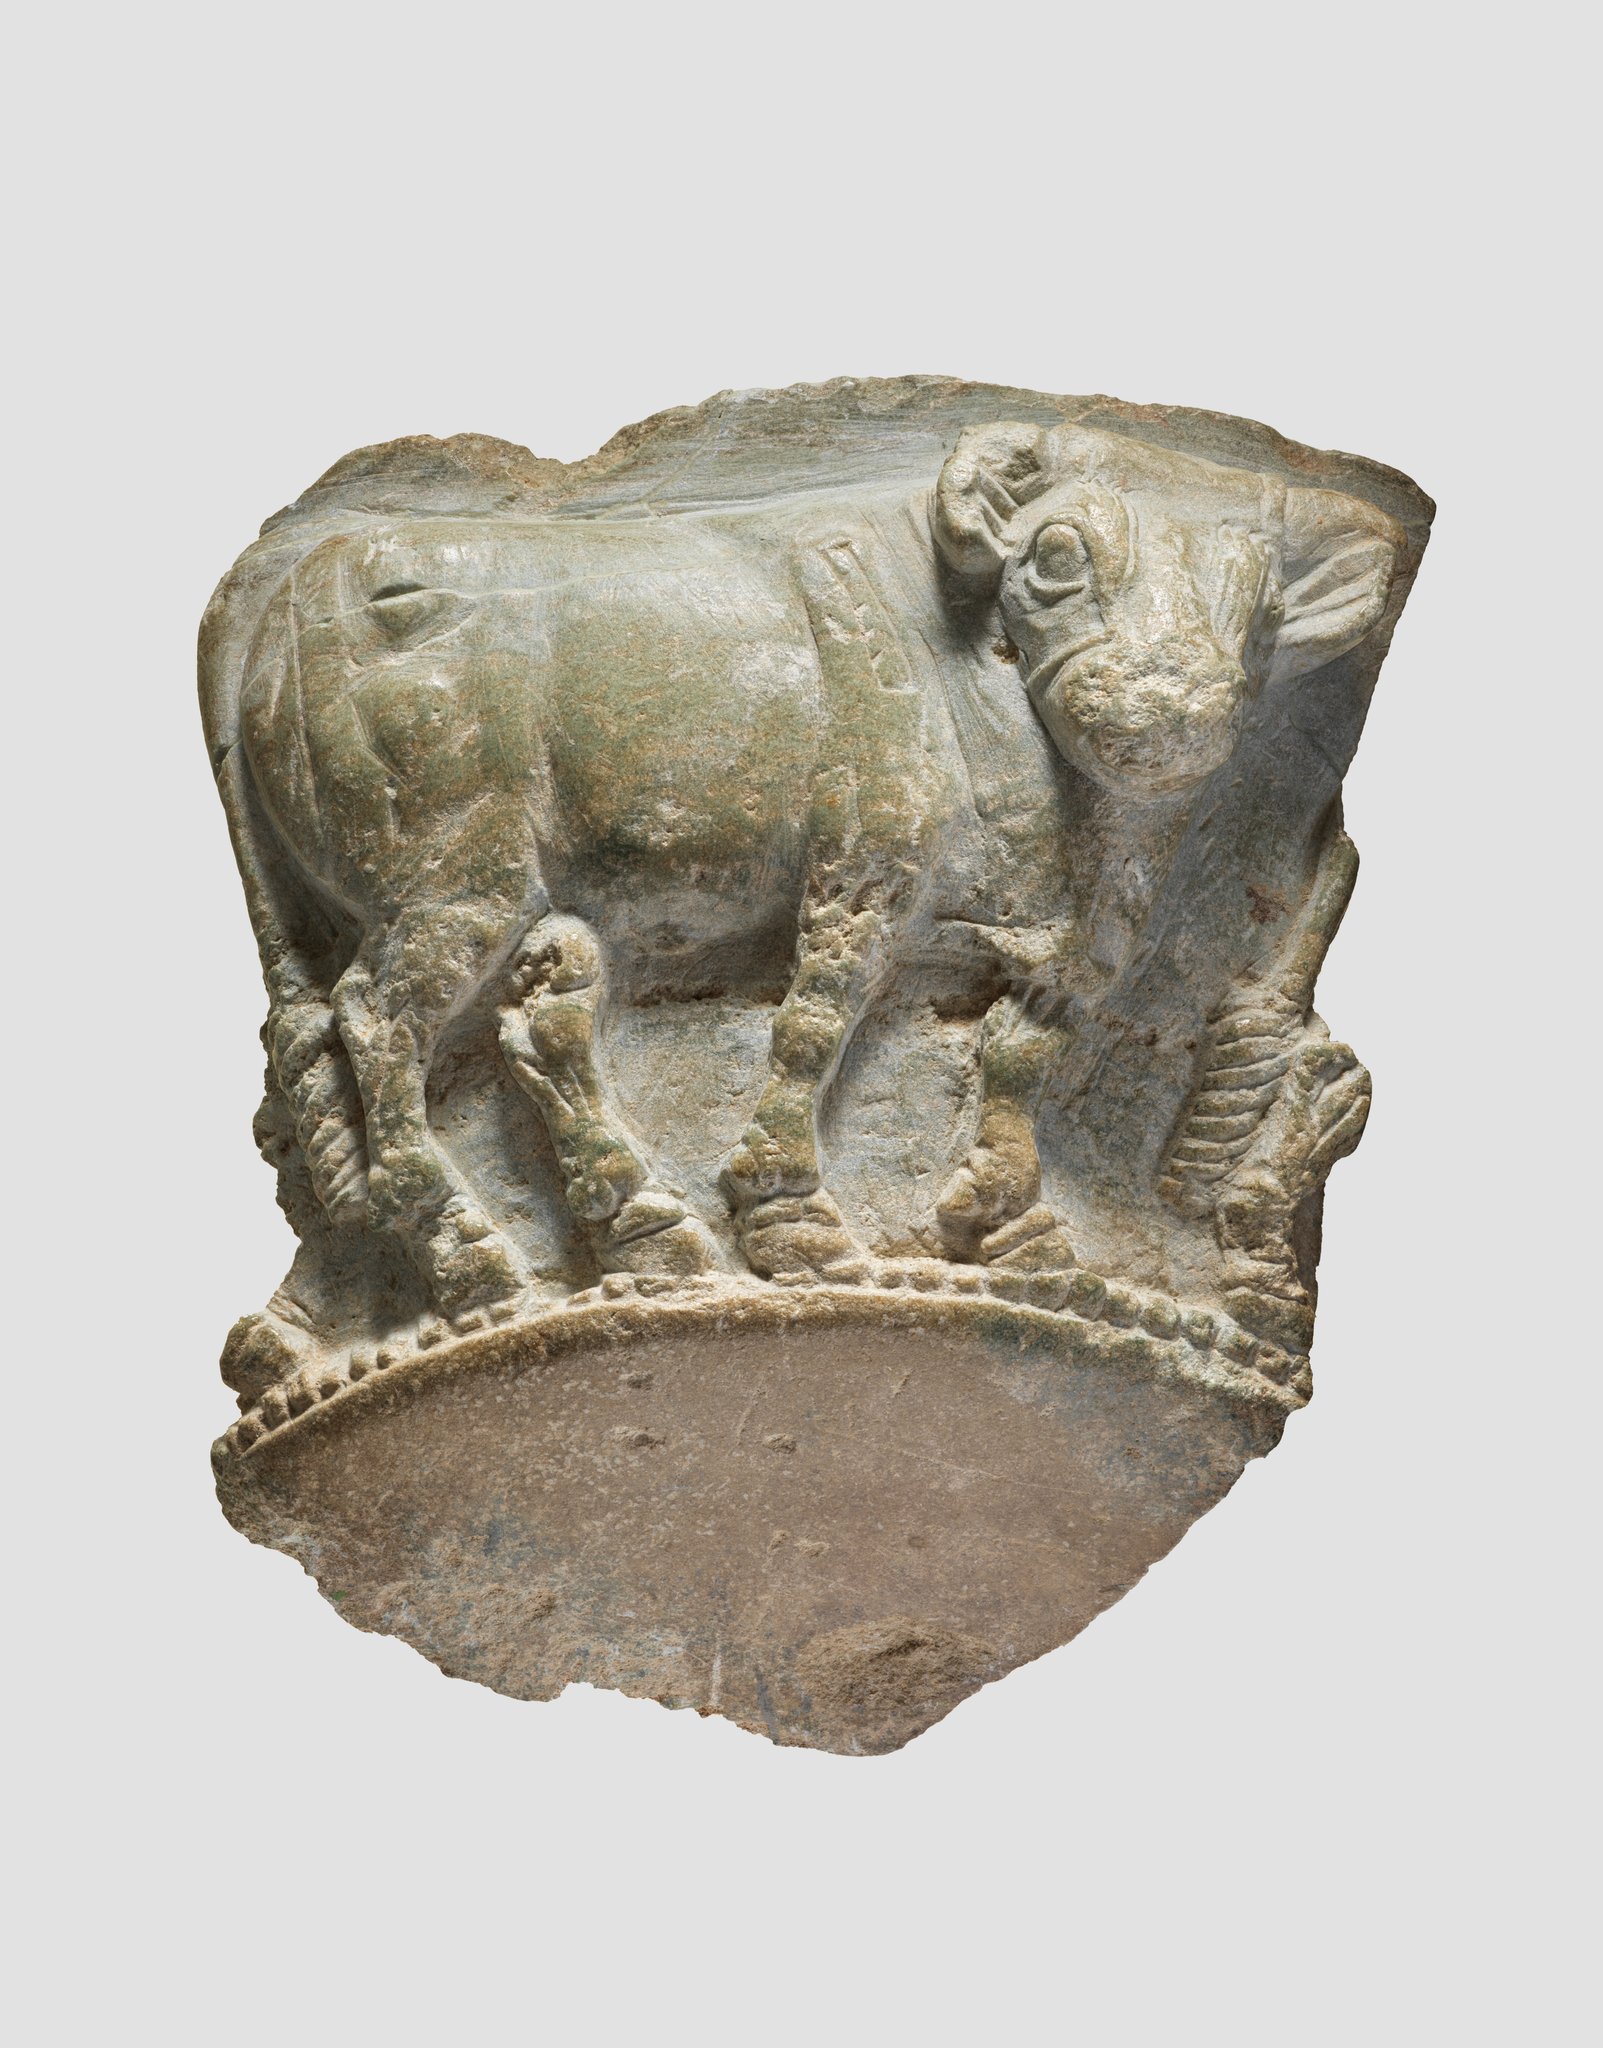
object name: bowl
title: Fragment of a bowl with a frieze of bulls in relief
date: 3300-2900 BCE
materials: mineral, stone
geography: southern mesopotamia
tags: bulls